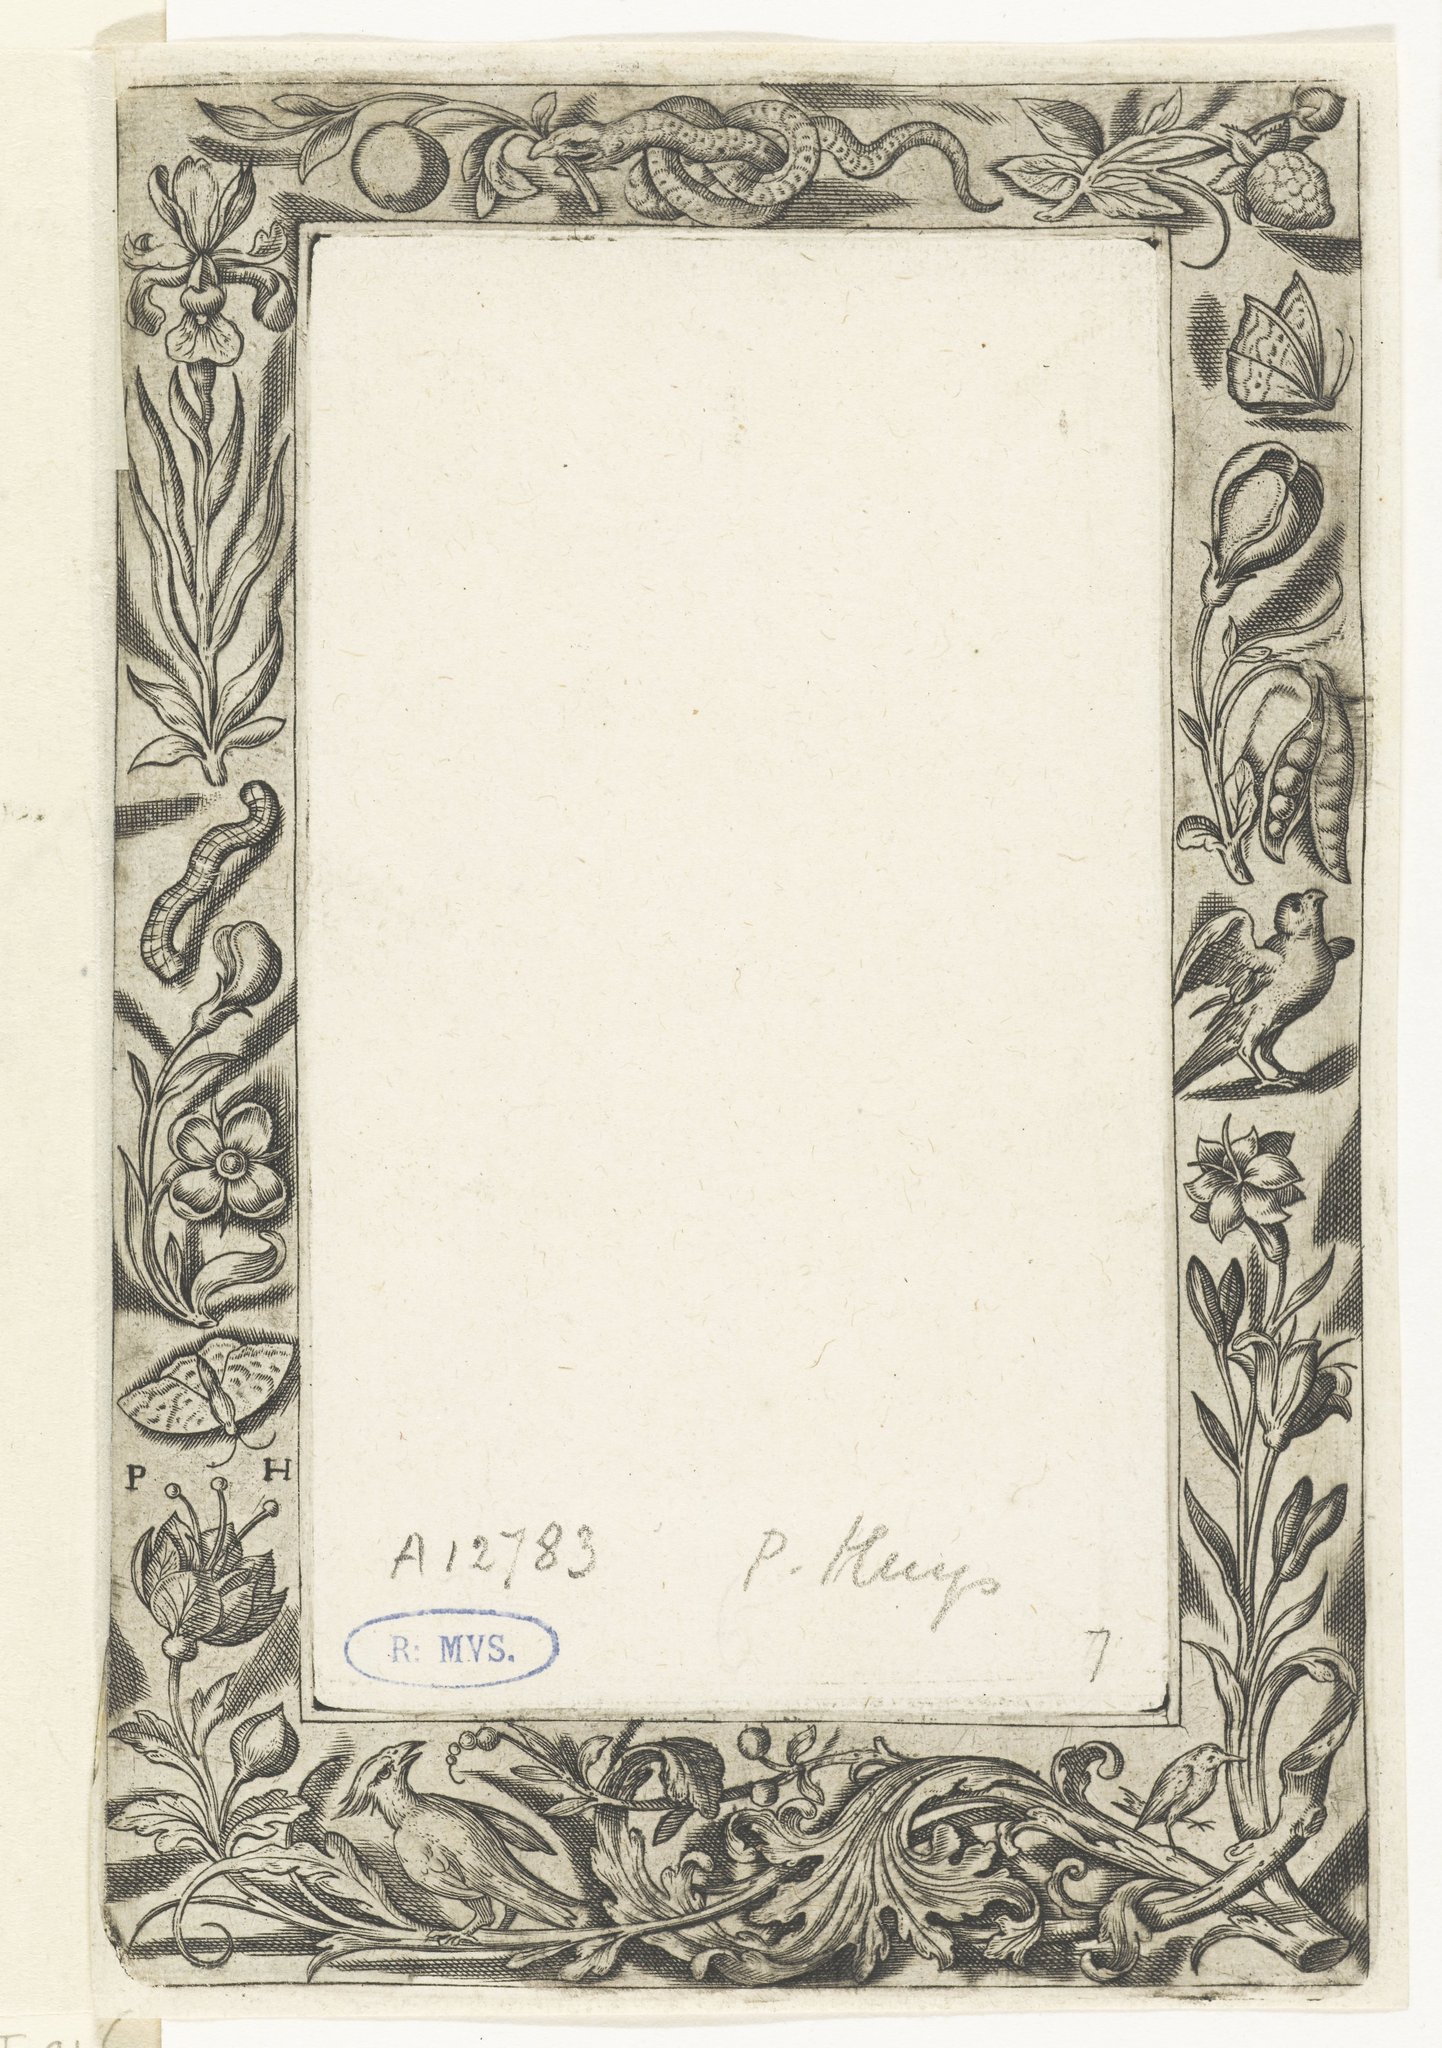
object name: print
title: Omlijstingen met bloemen, vruchten, vogels, insekten en putti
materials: paper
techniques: etching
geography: netherlands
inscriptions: inscription: ‘7’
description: Middenboven ligt een ineen gekronkelde slang met in zijn bek een tak waaraan een kers hangt. Eén van 6 bladen, aan weerszijden bedrukt, met acht verschillende omlijstingen rondom een niet bedrukt middenveld.